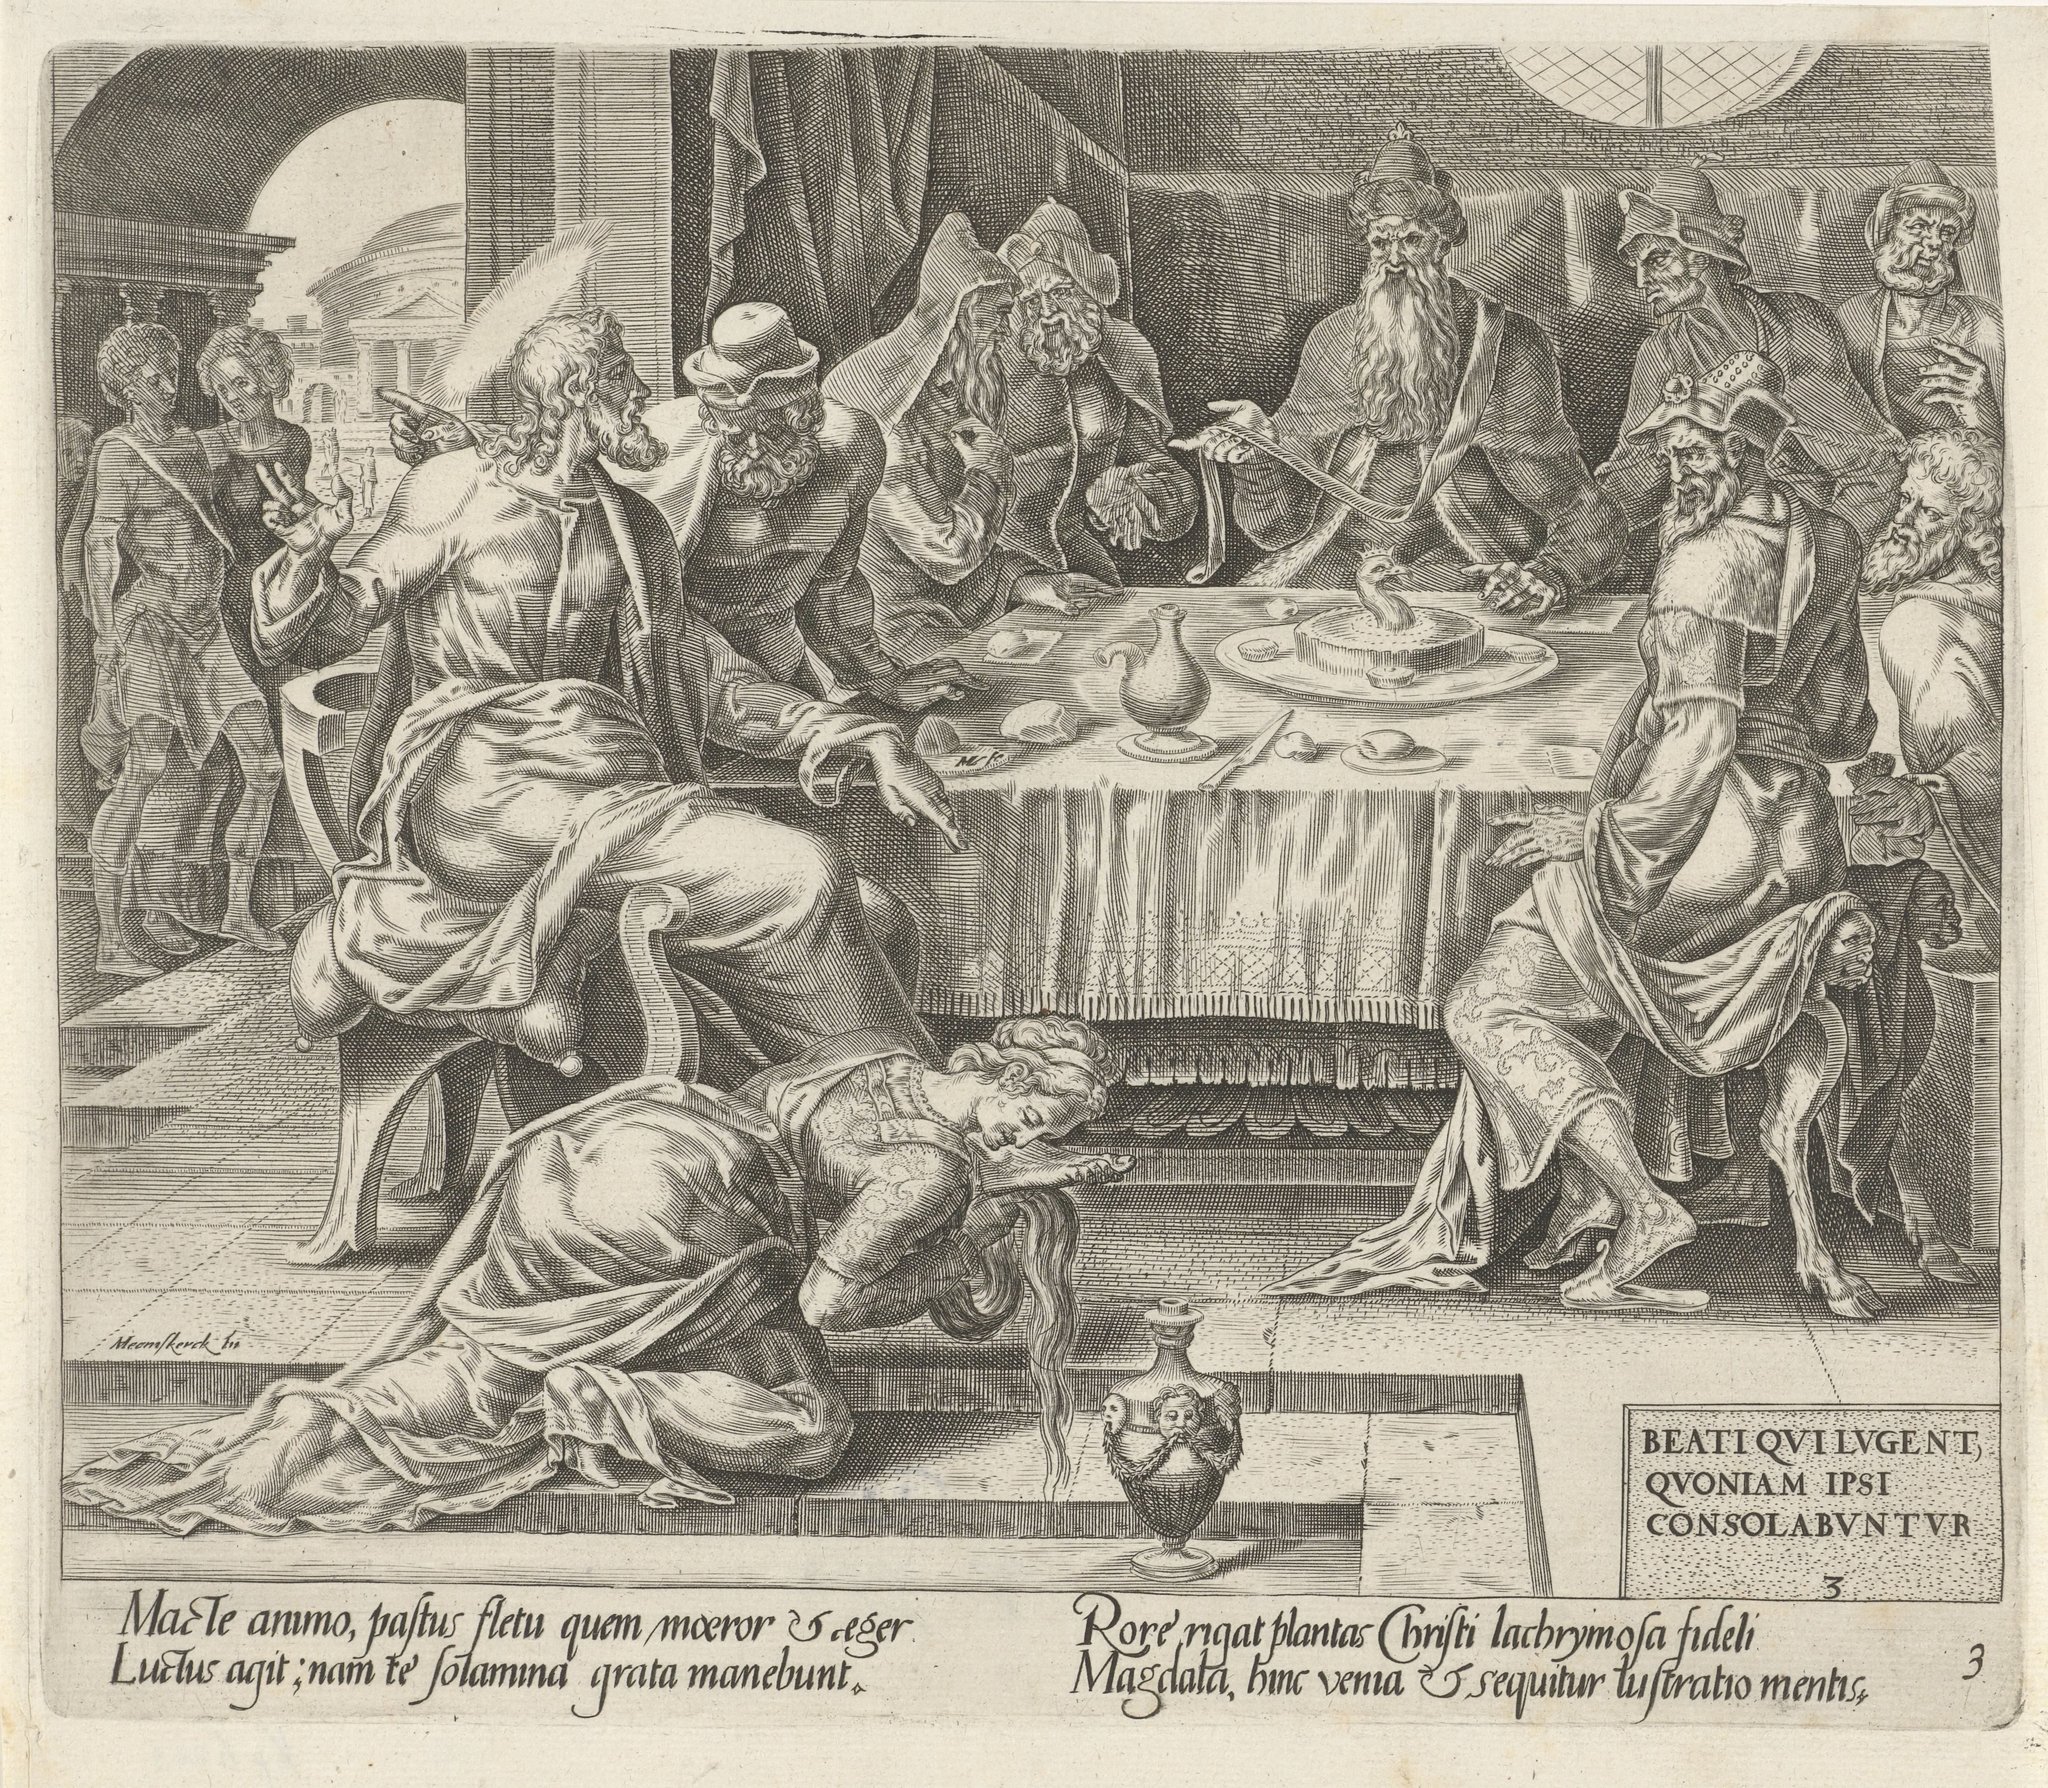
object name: print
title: Zalig zijn de treurenden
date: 1564-1568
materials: paper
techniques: engraving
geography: antwerp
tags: blessed are those who mourn, christ's feet are anointed by mary (magdalene)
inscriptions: collector's mark: Lugt 2228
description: Christus zit aan tafel te eten in het huis van Simon de Farizeeër. Maria Magdalena knielt op de grond zalft zijn voeten en droogt ze met haar haren. Prent maakt deel uit van een serie over de acht zaligsprekingen van Christus en illustreert de zaligspreking: Zalig de treurenden. In de rechter benedenhoek deze tekst uit Mat. 5:4 in het Latijn. Onderaan in de marge een vers in het Latijn over de zaligspreking en de voorstelling.